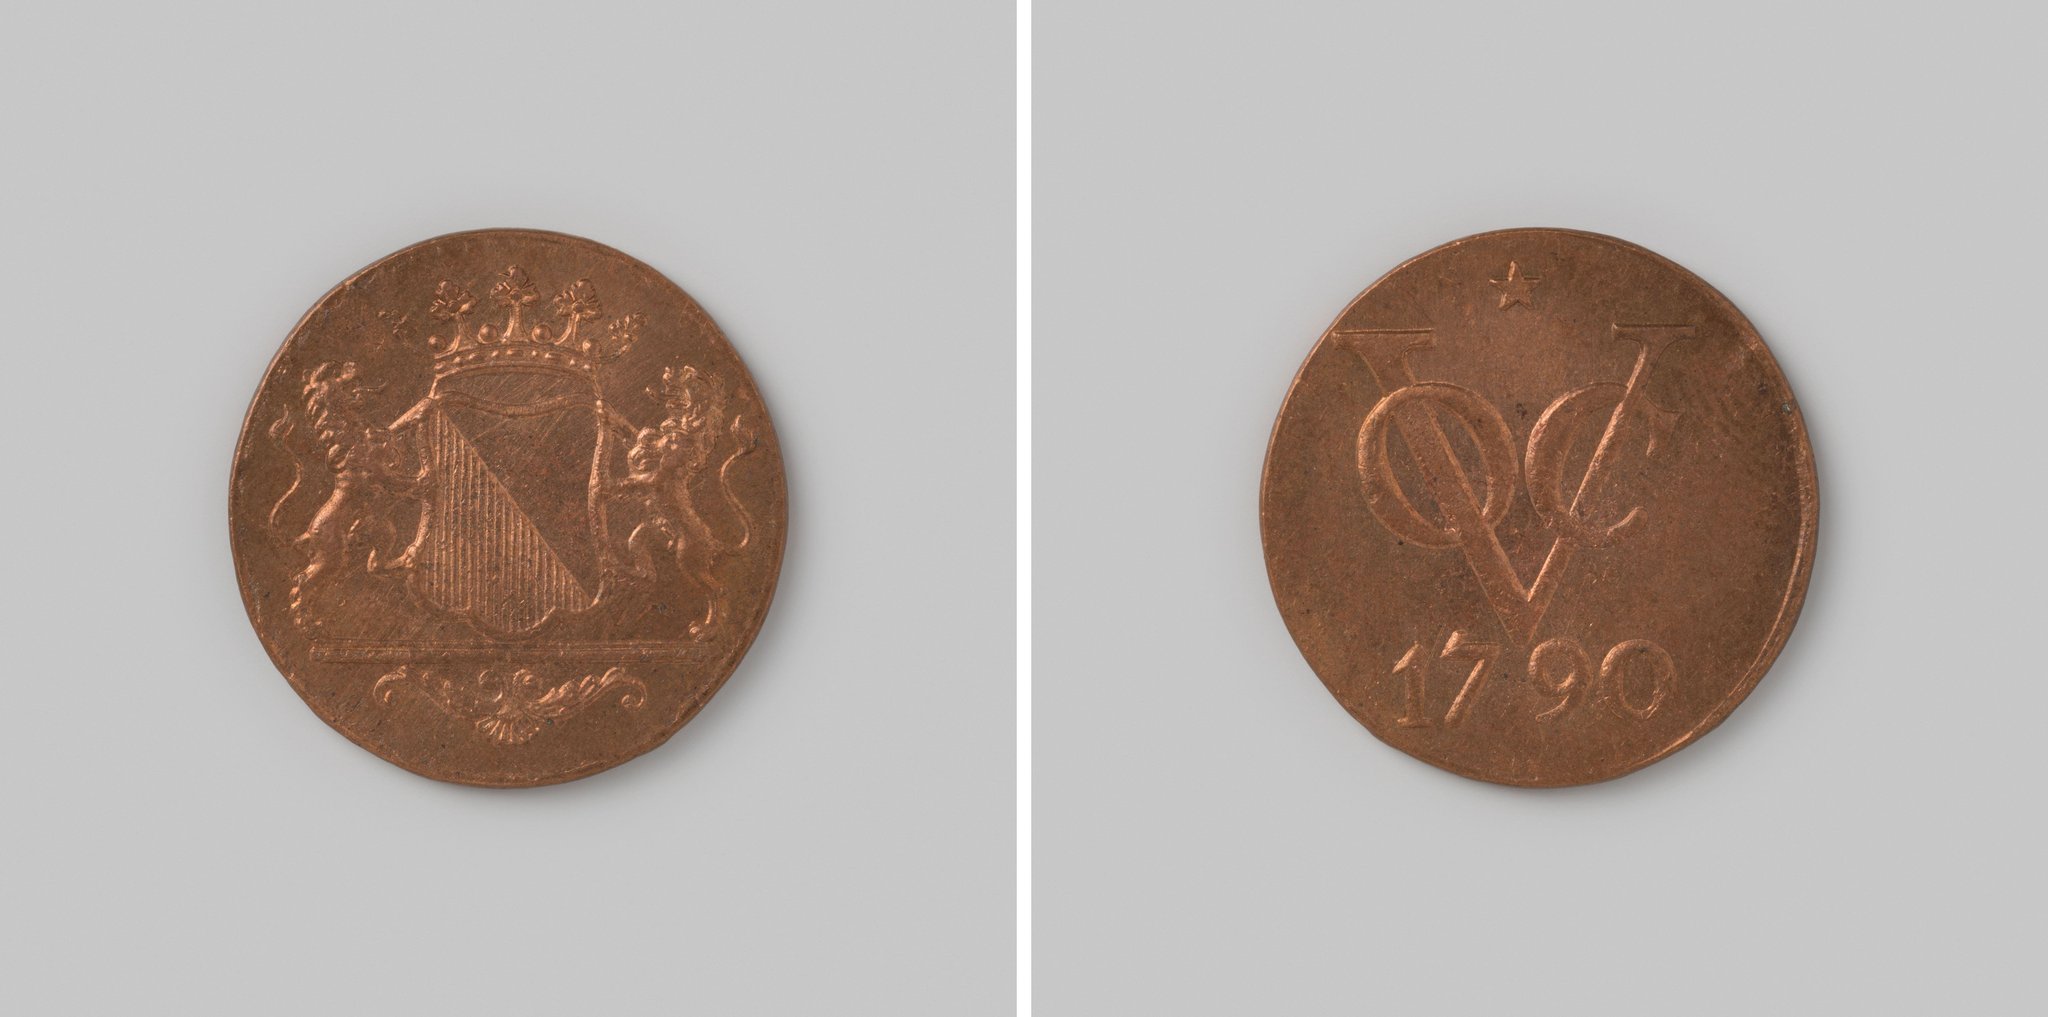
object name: coin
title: VOC, dubbele duit op naam van de stad Utrecht met jaartal1790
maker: william ii of the netherlands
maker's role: koning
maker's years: 1792-1849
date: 1840-1843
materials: copper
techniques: striking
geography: surabaya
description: Koperen munt. Voorzijde: op balk, waaronder guirlande, staand, door twee leeuwen gehouden gekroond wapenschild van de stad Utrecht. Keerzijde: monogram van de VOC, waarboven muntteken ster en waaronder fictief jaartal 1790. Gladde rand.